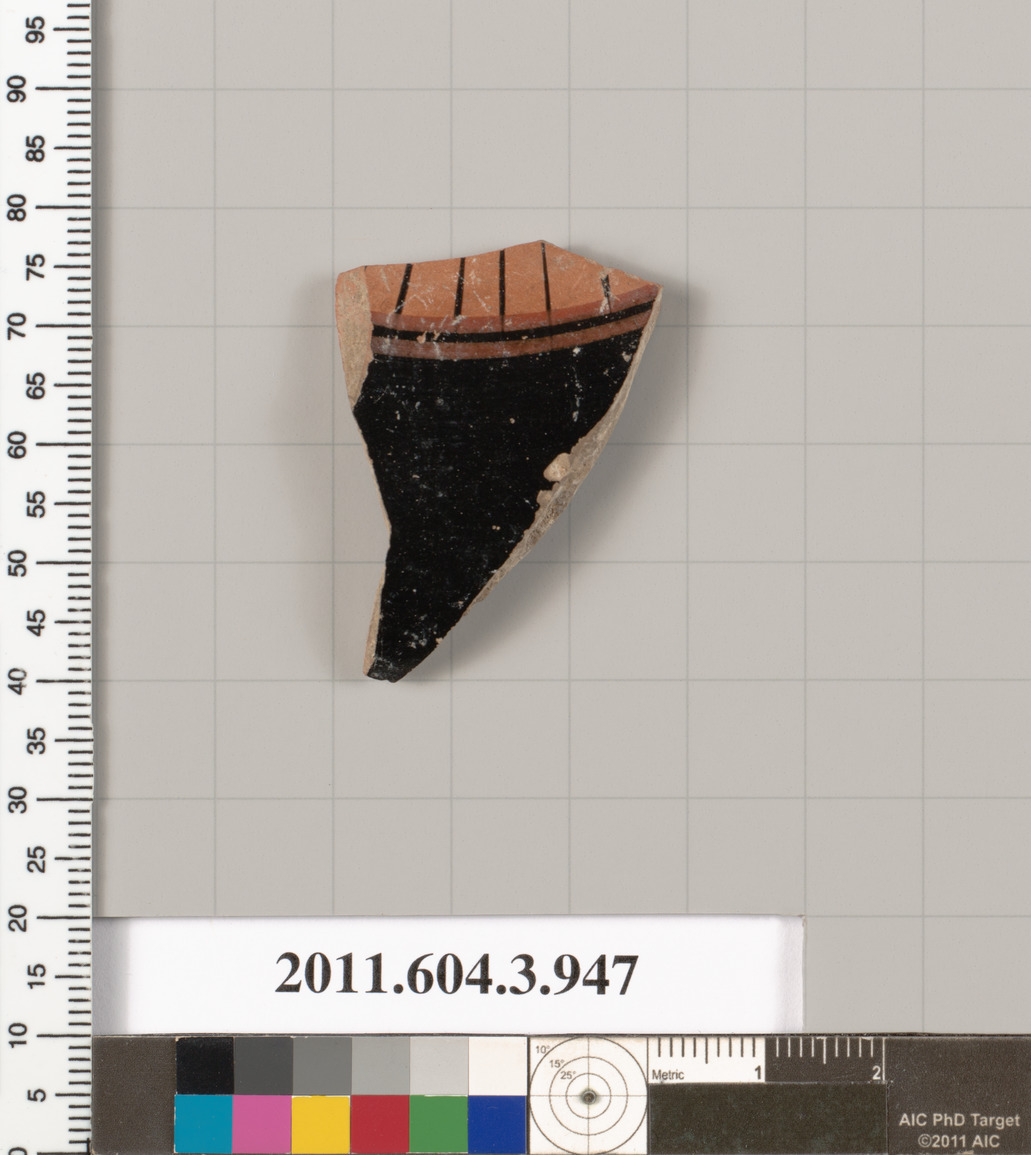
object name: lekanis lid fragment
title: Terracotta fragment of a lekanis lid (covered dish)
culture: greek, attic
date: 600-501 BCE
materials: terracotta